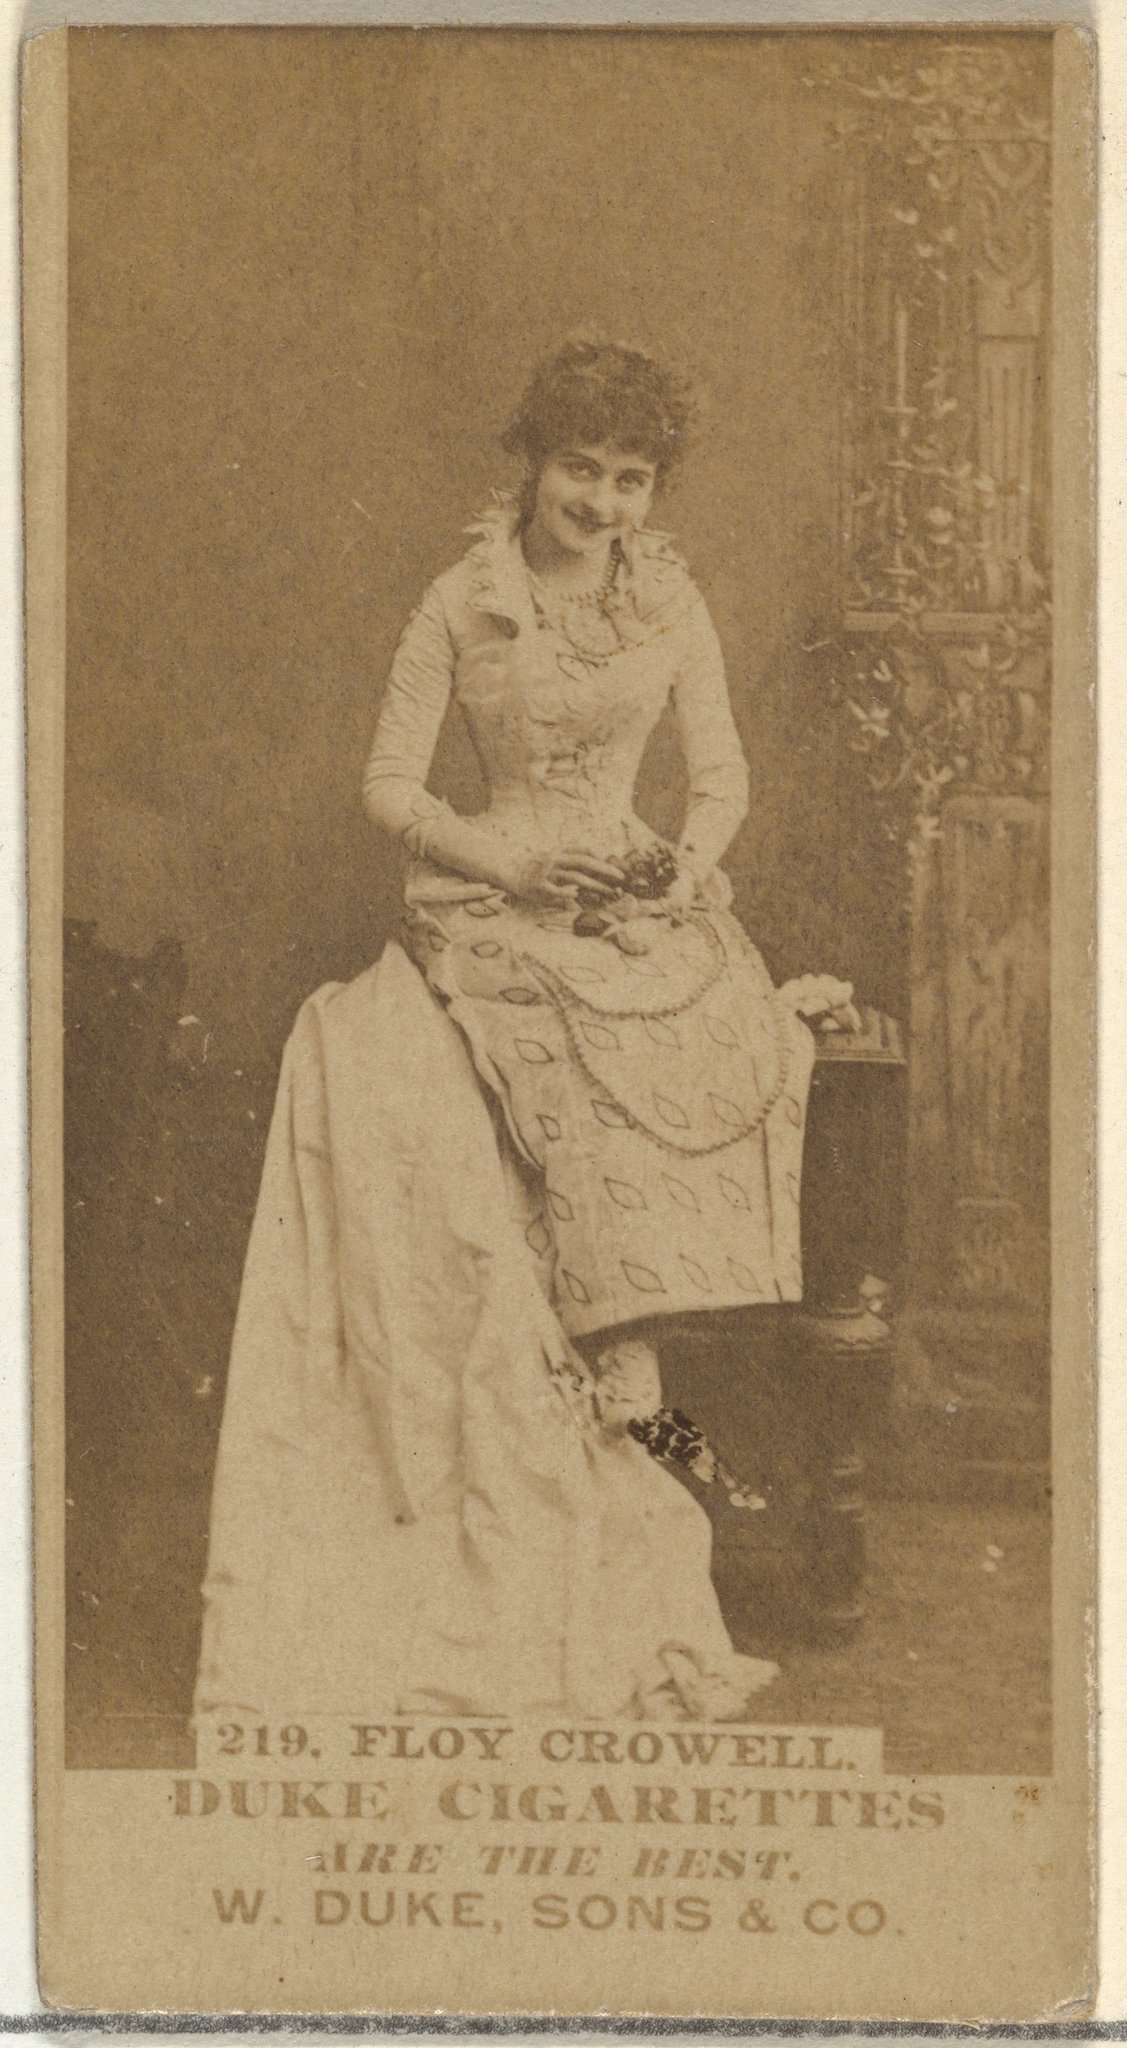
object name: photograph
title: Card Number 219, Floy Crowell, from the Actors and Actresses series (N145-7) issued by Duke Sons & Co. to promote Duke Cigarettes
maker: w. duke, sons & co.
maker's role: publisher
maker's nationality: american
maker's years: 1870-1920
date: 1880-1889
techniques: albumen silver print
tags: portraits,women,actresses